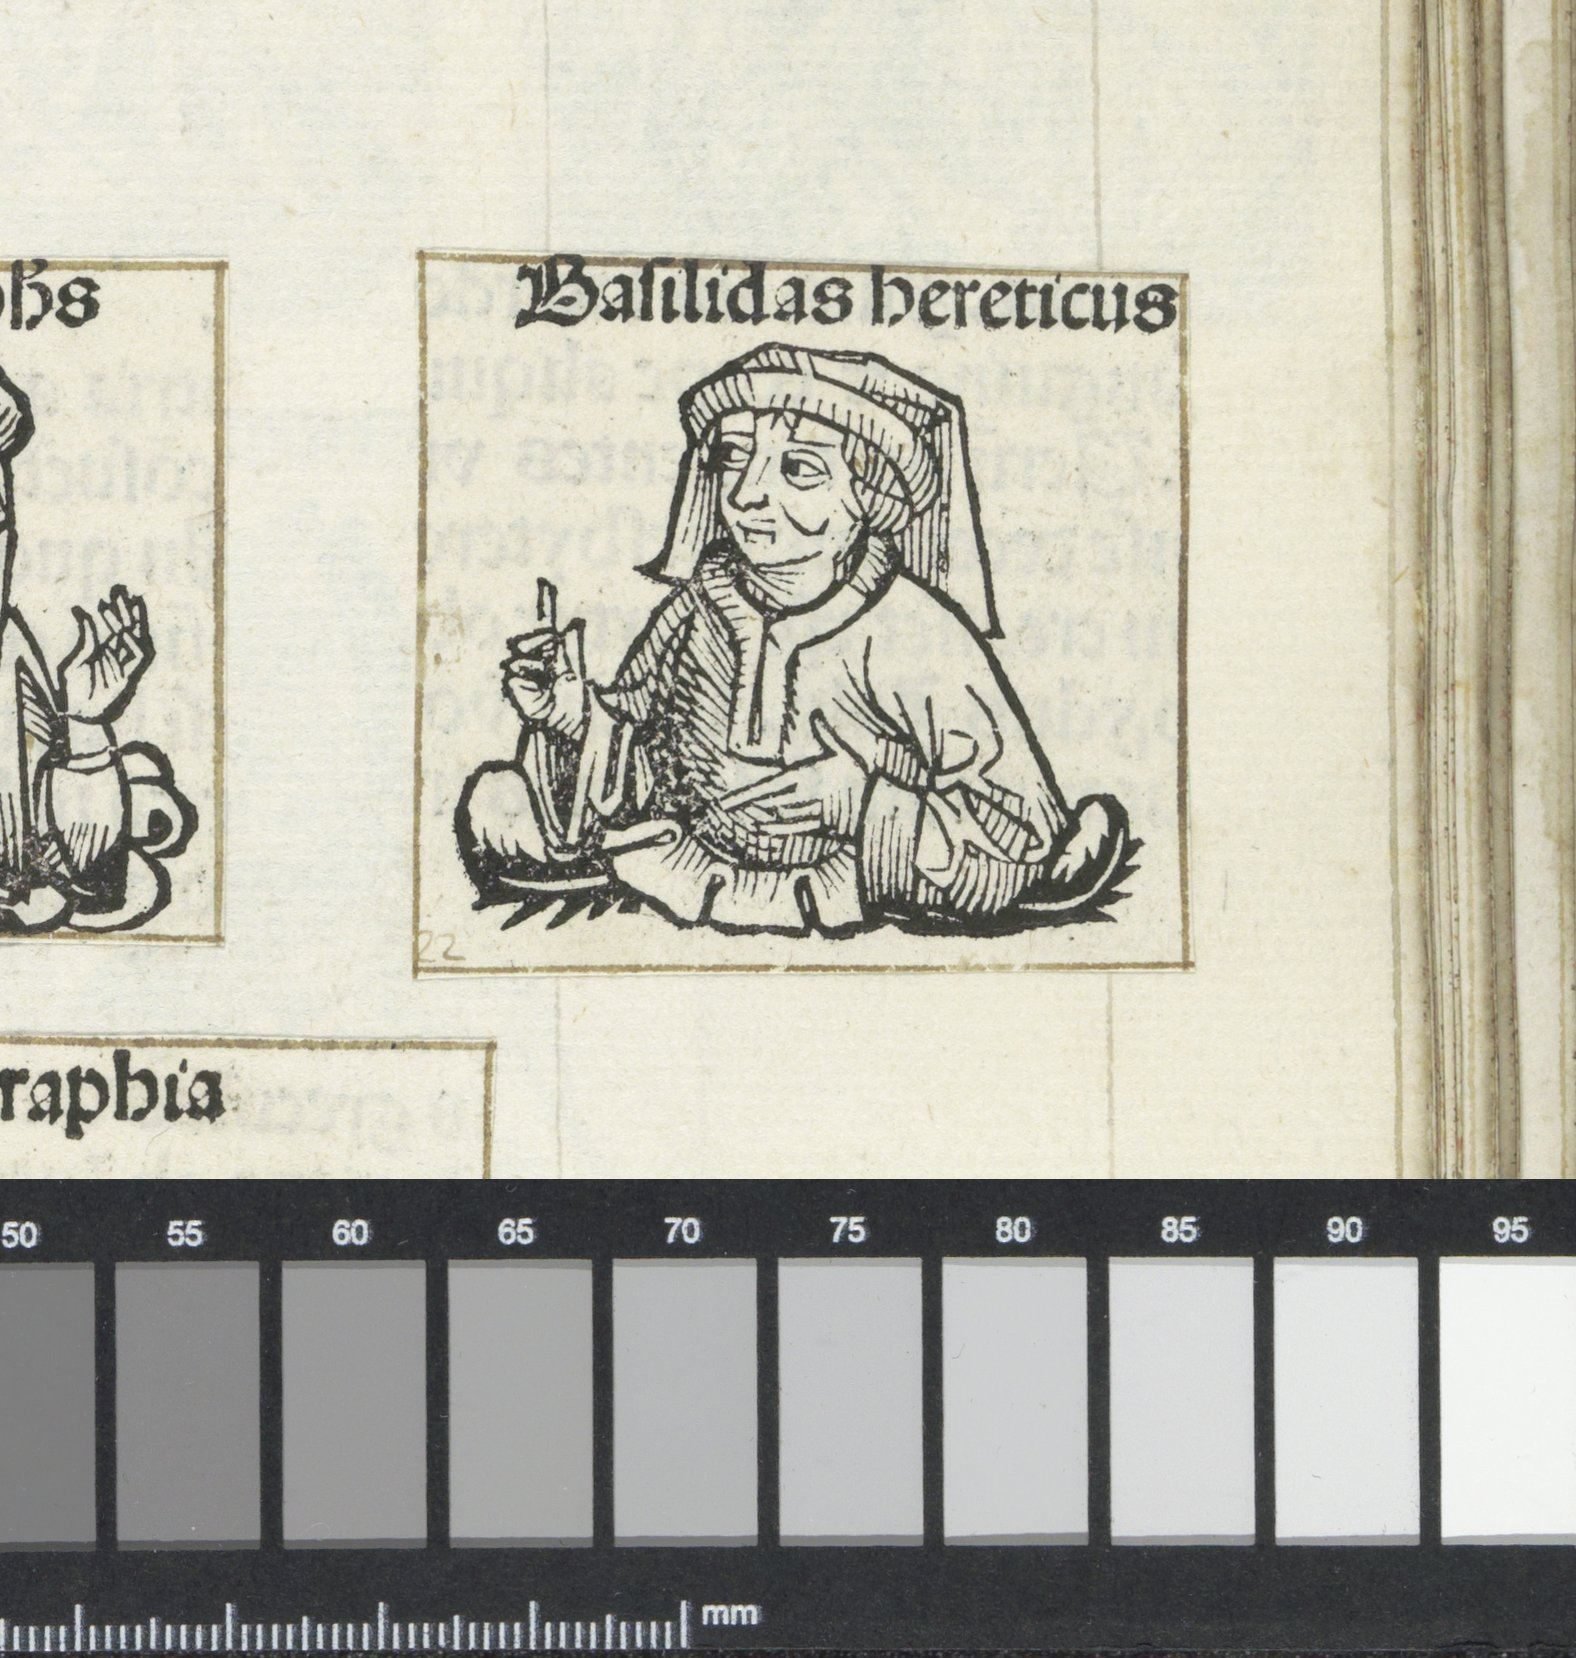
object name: print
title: Basilidas hereticus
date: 1493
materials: paper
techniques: letterpress printing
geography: nuremberg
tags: male persons from classical history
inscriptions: inscription: ‘22’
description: De houtsnede wordt herhaaldelijk gebruikt als boekillustratie in de Liber Chronicarum (of Neurenbergkroniek) van Hartmann Schedel, verschenen in het Latijn en Duits in 1493. Zie de Latijnse uitgave, folio 111r.